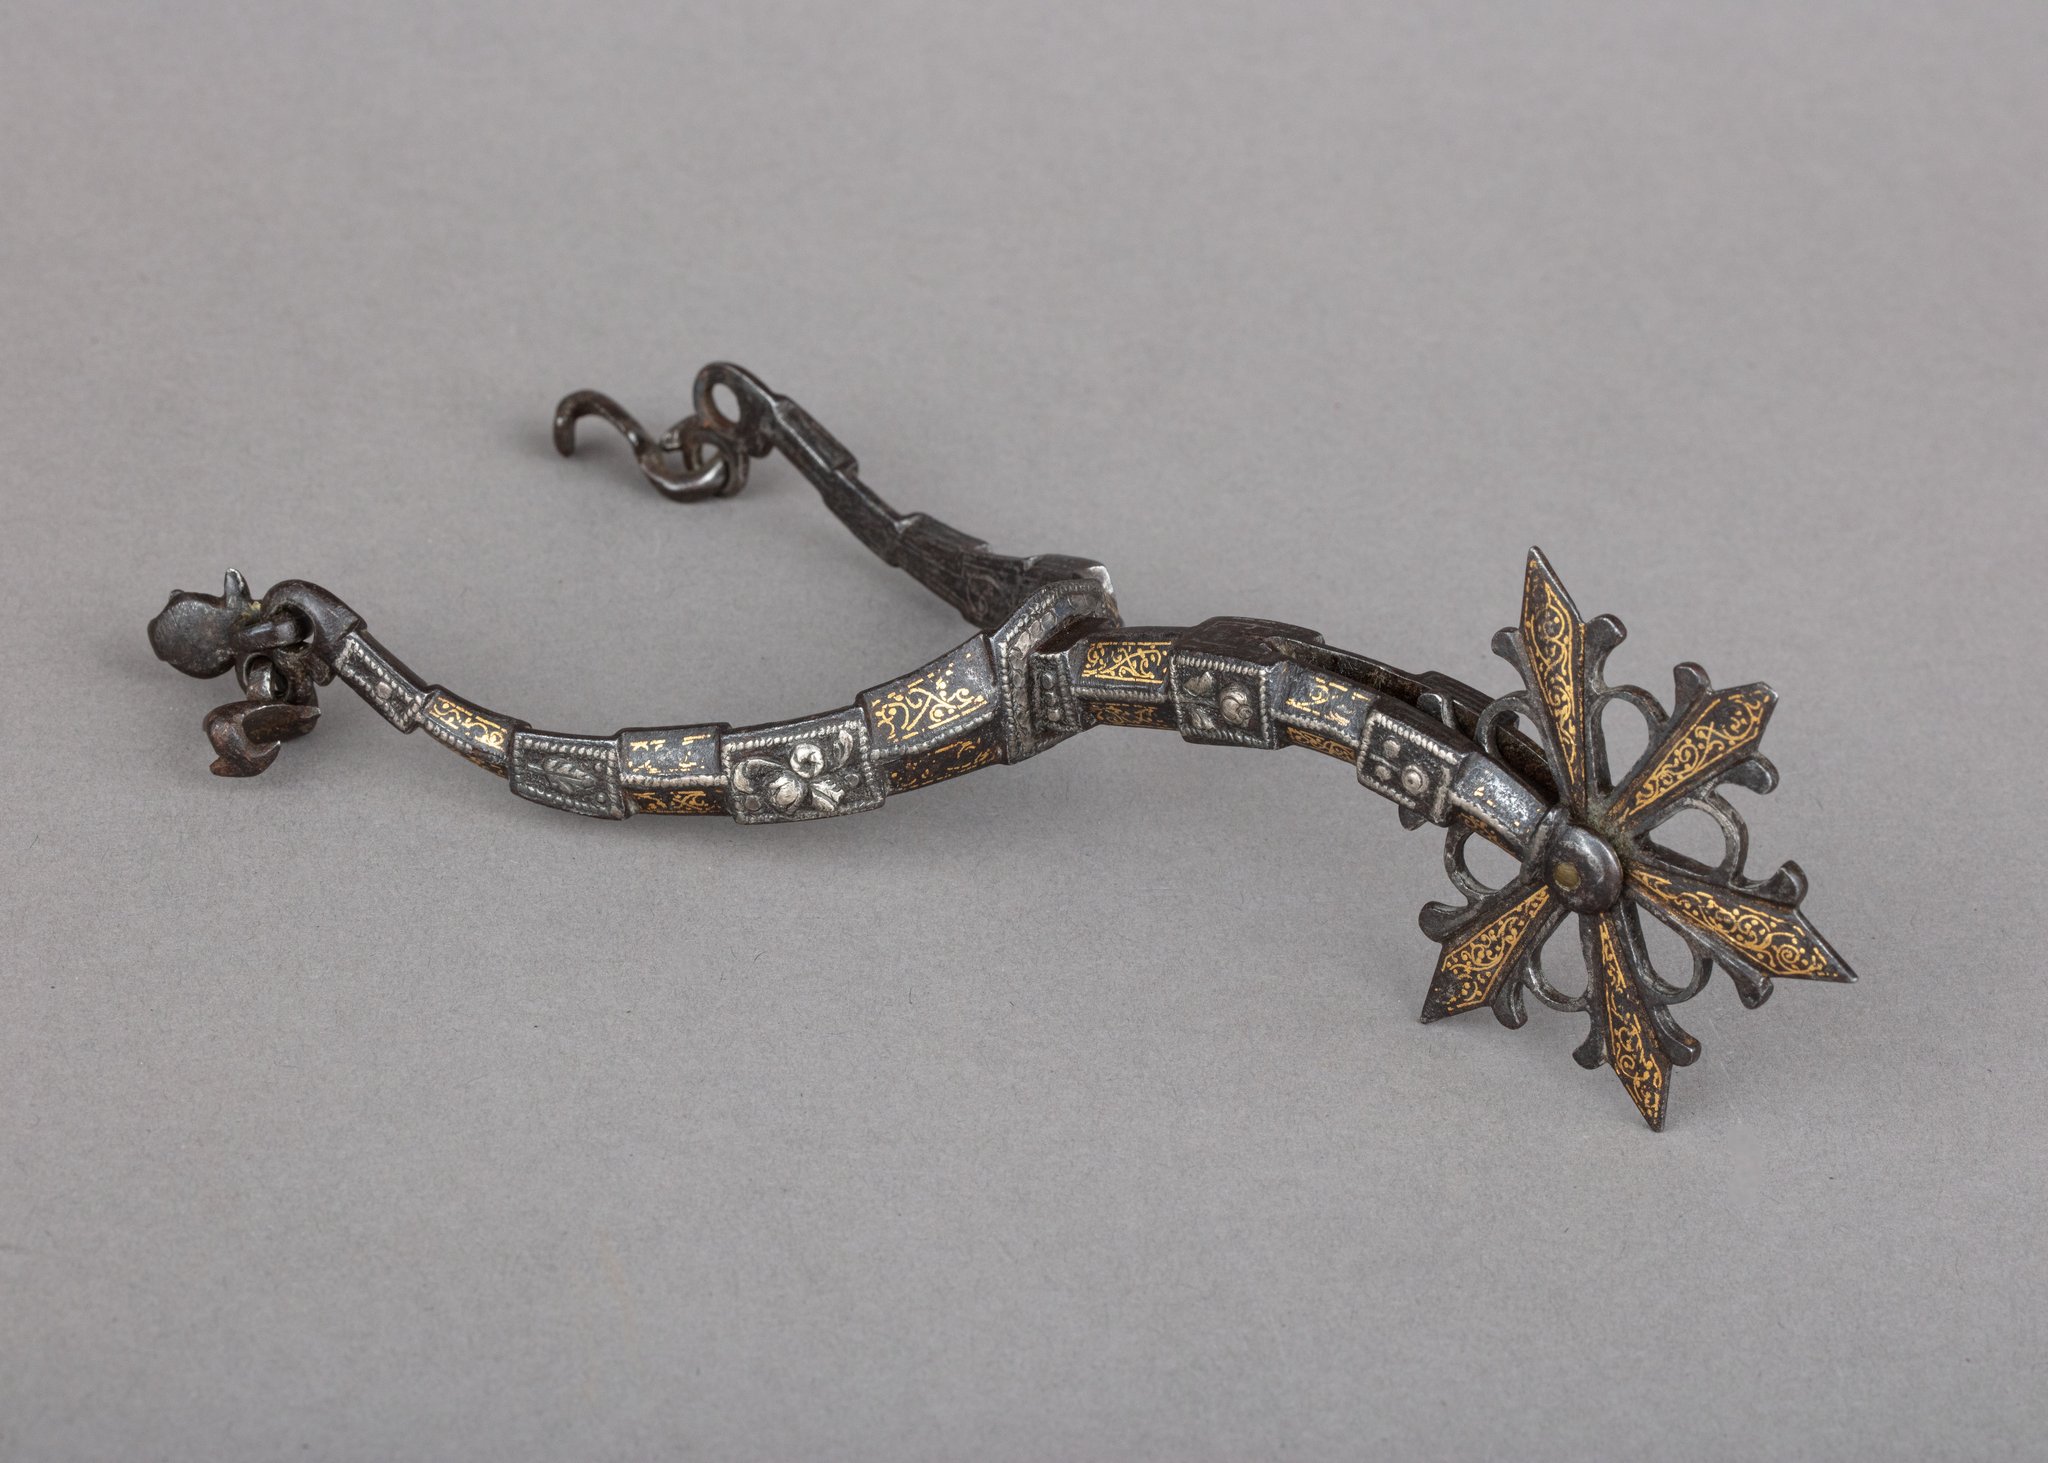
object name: spur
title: Rowel Spur (Right)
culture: british or german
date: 1601-1633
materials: gold, metal alloy, silver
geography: germany